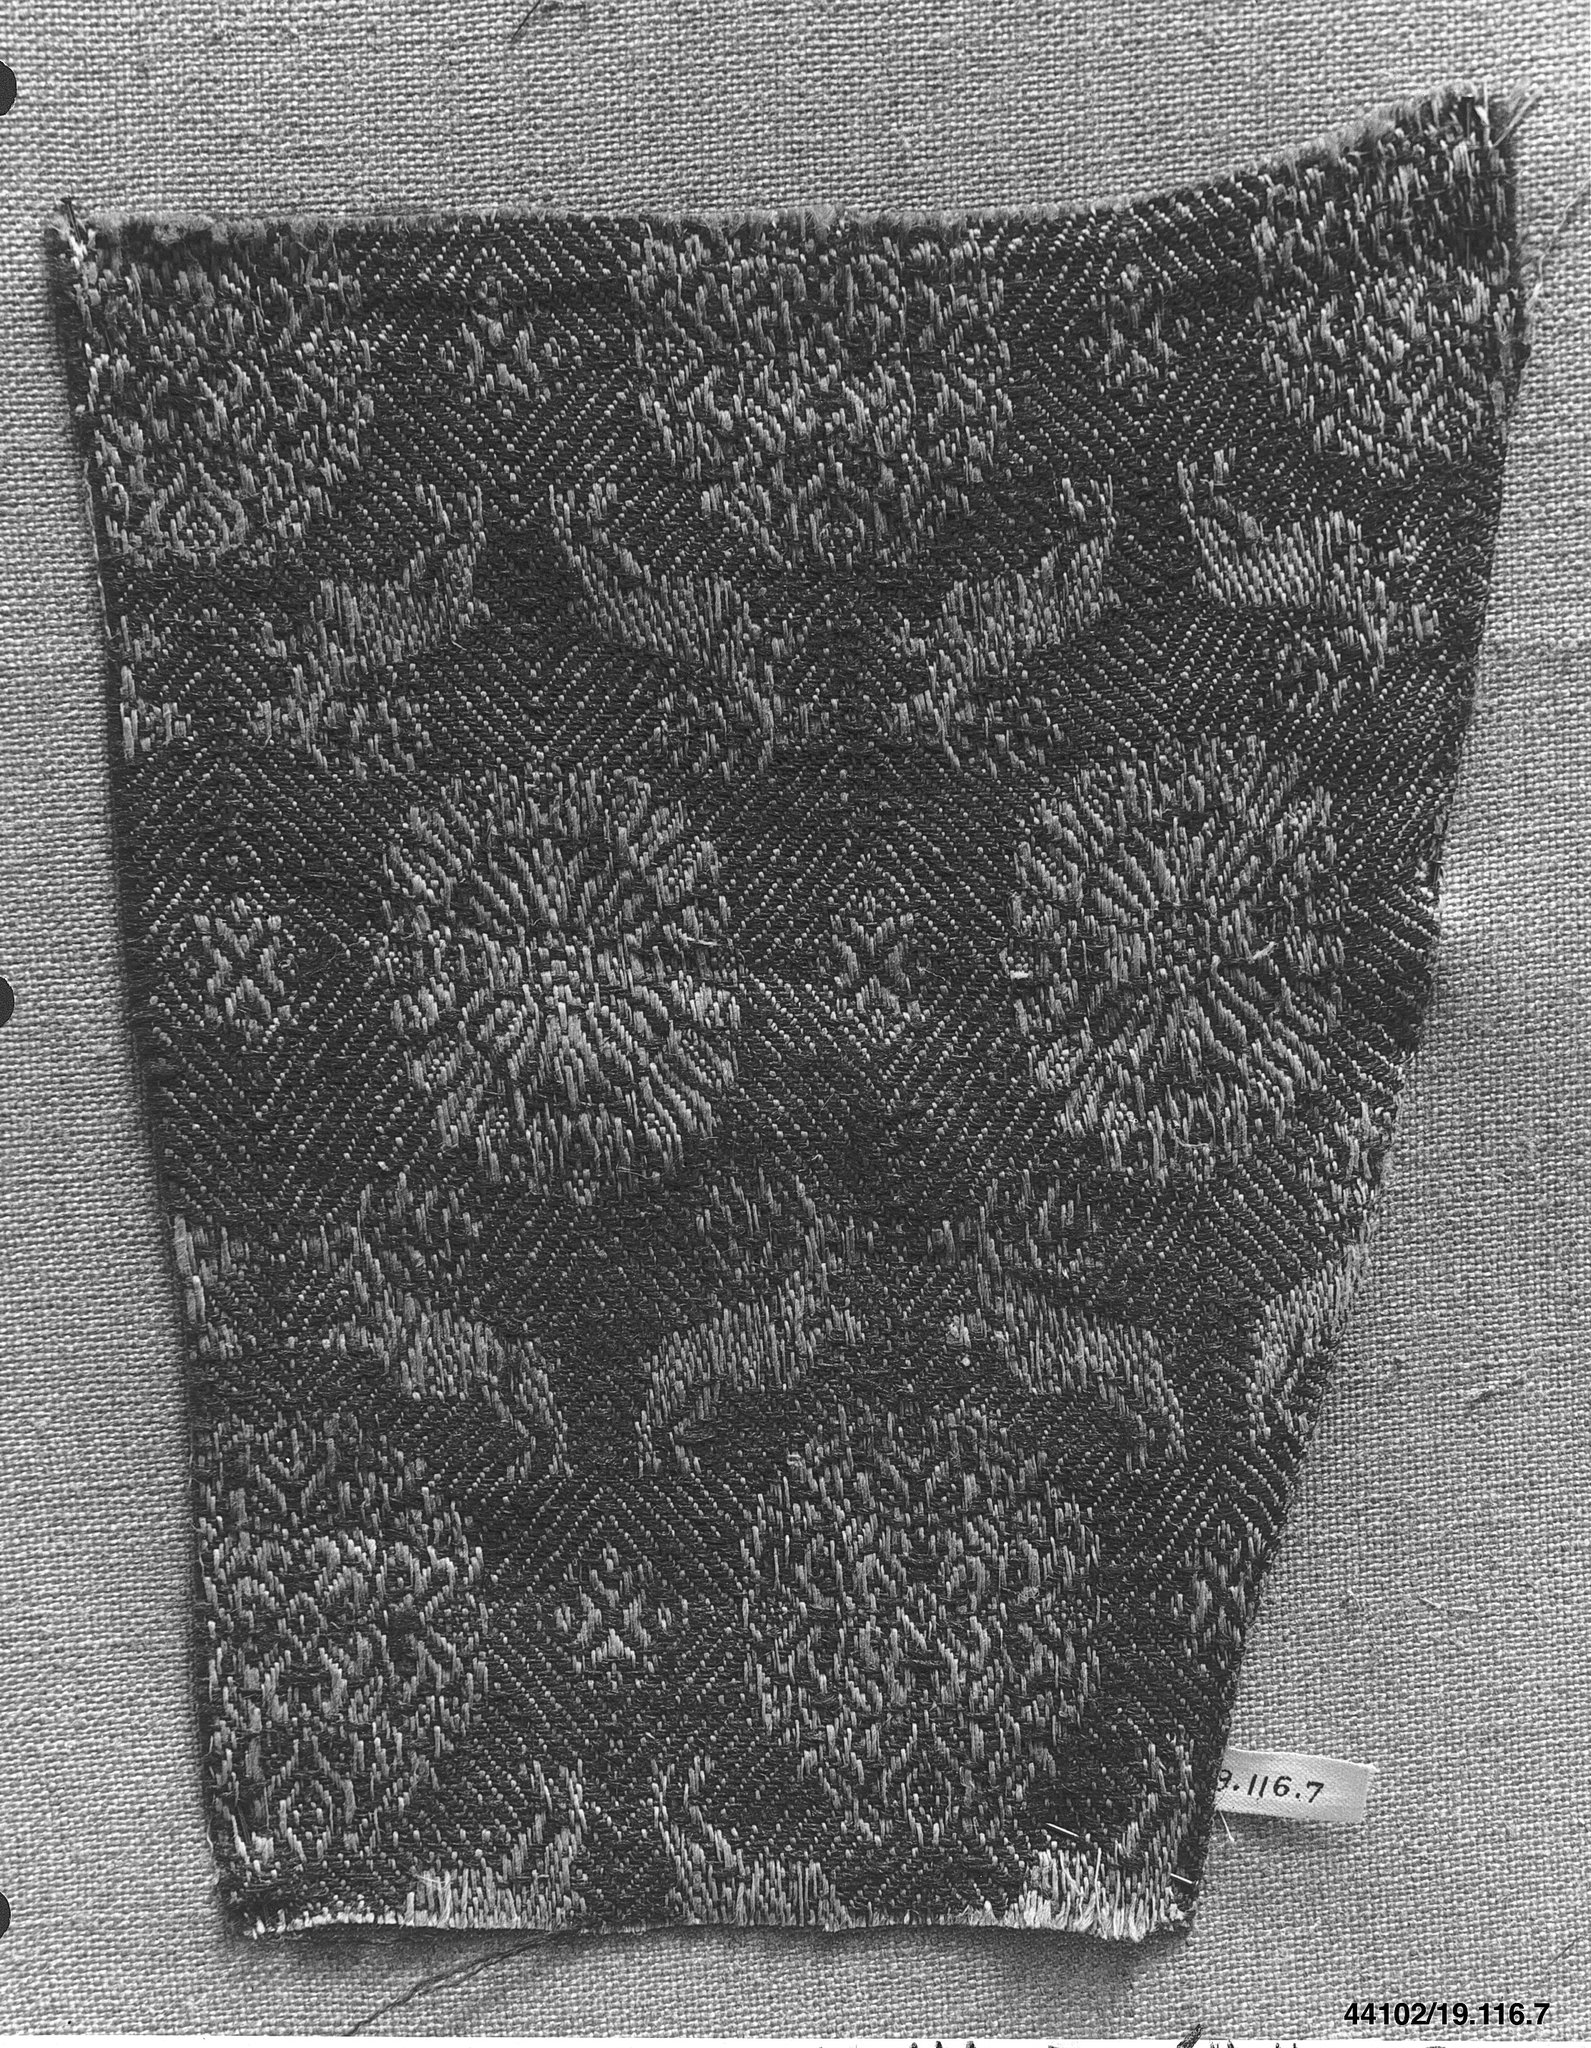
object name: fragment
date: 1501-1600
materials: cotton, wool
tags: deer,flowers